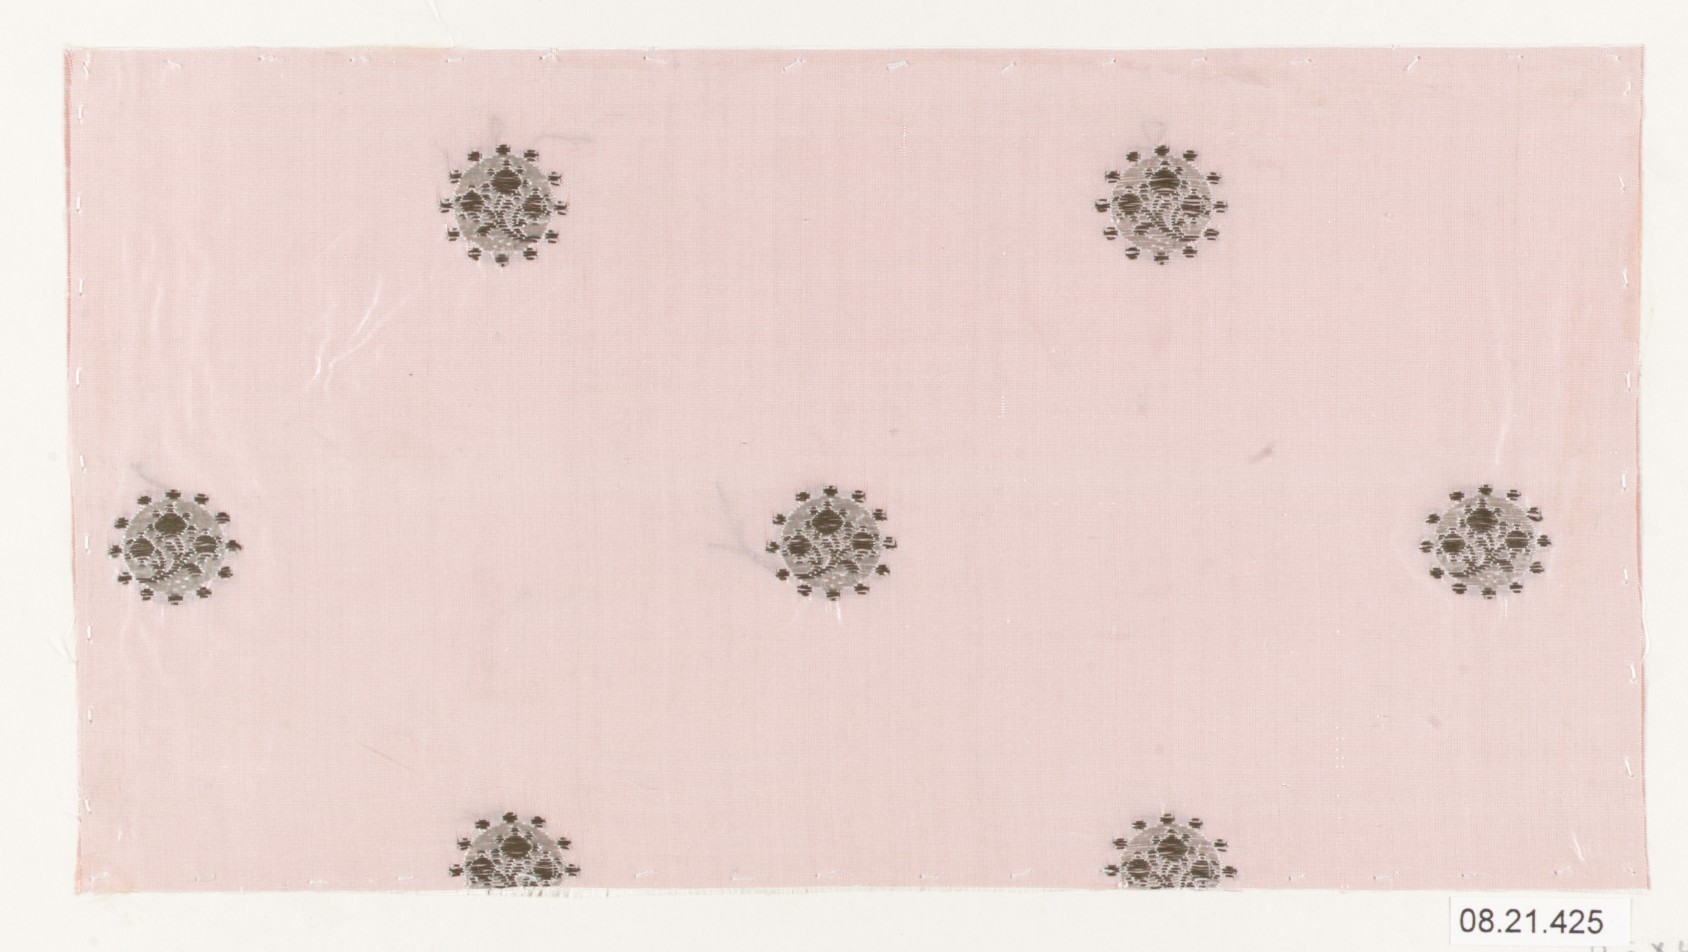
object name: textile sample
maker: Anonymous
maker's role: designer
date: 1900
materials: silk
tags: flowers